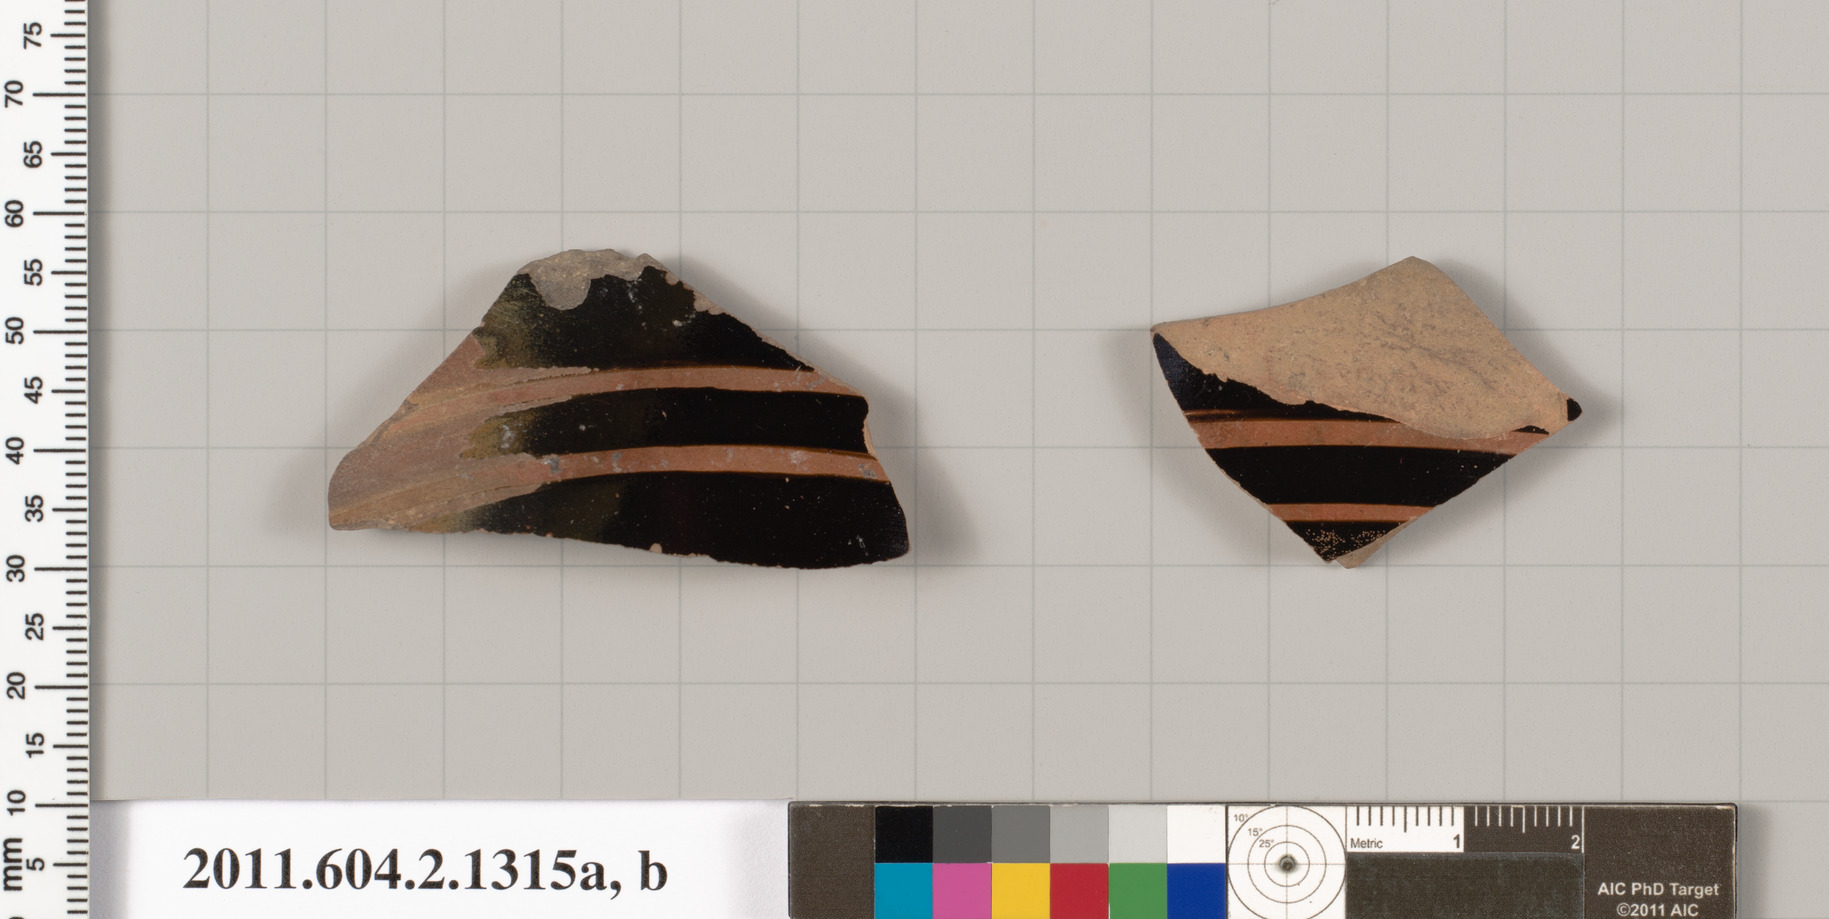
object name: skyphos fragment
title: Terracotta fragments of skyphoi (deep drinking cups)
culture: greek, attic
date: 401-425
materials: terracotta